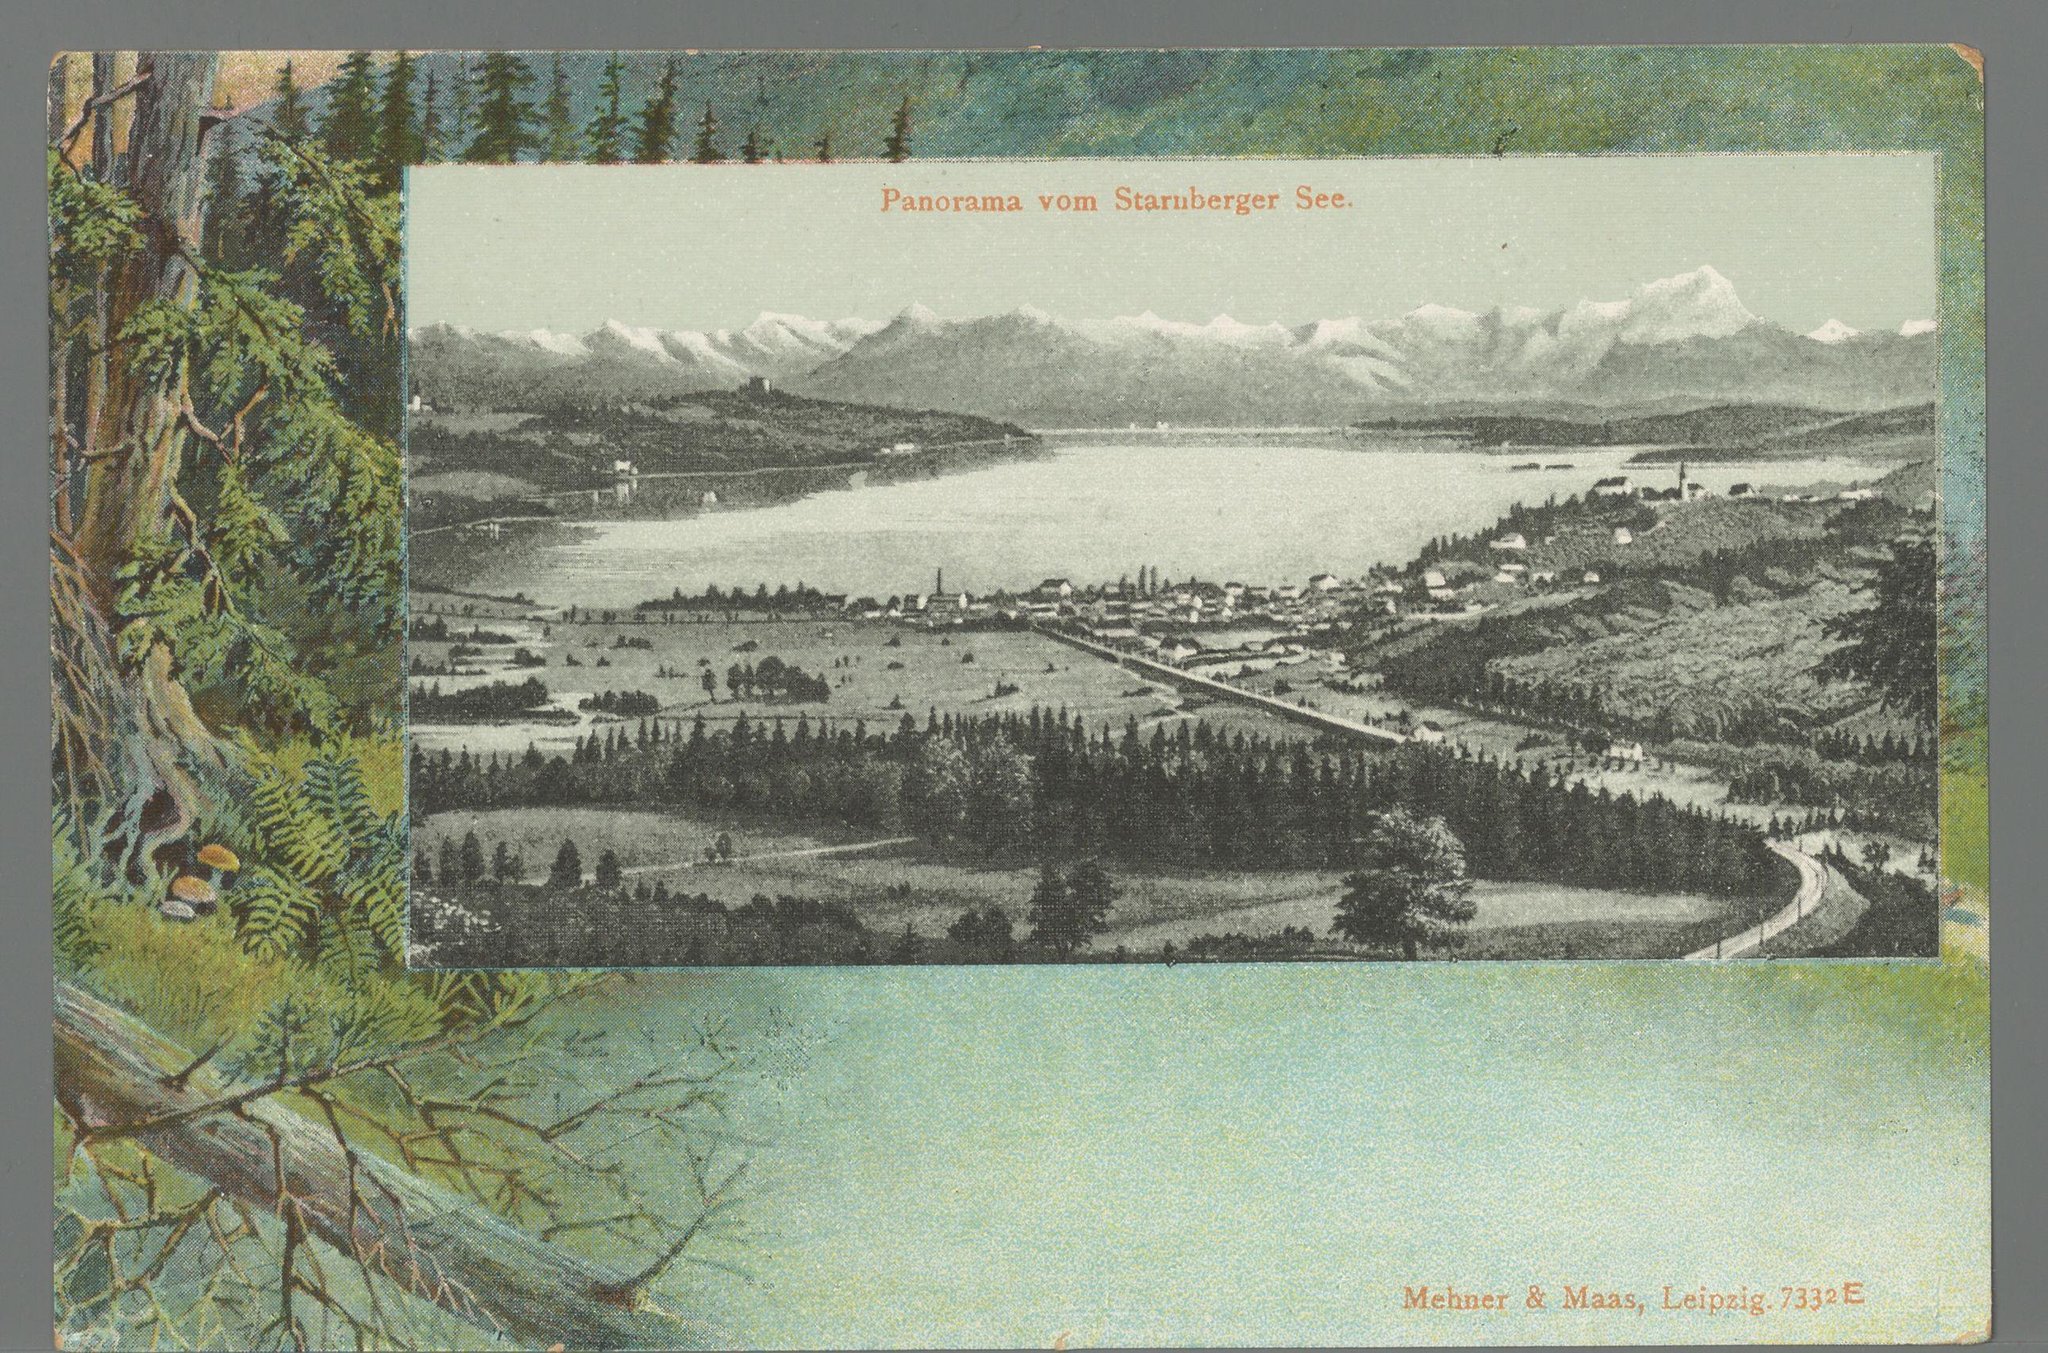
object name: photomechanical print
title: Panorama vom Starnberger See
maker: Anonymous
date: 1901-1905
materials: cardboard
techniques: lithograph, writing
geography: leipzig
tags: city-view, and landscape with man-made constructions, lake, mountains